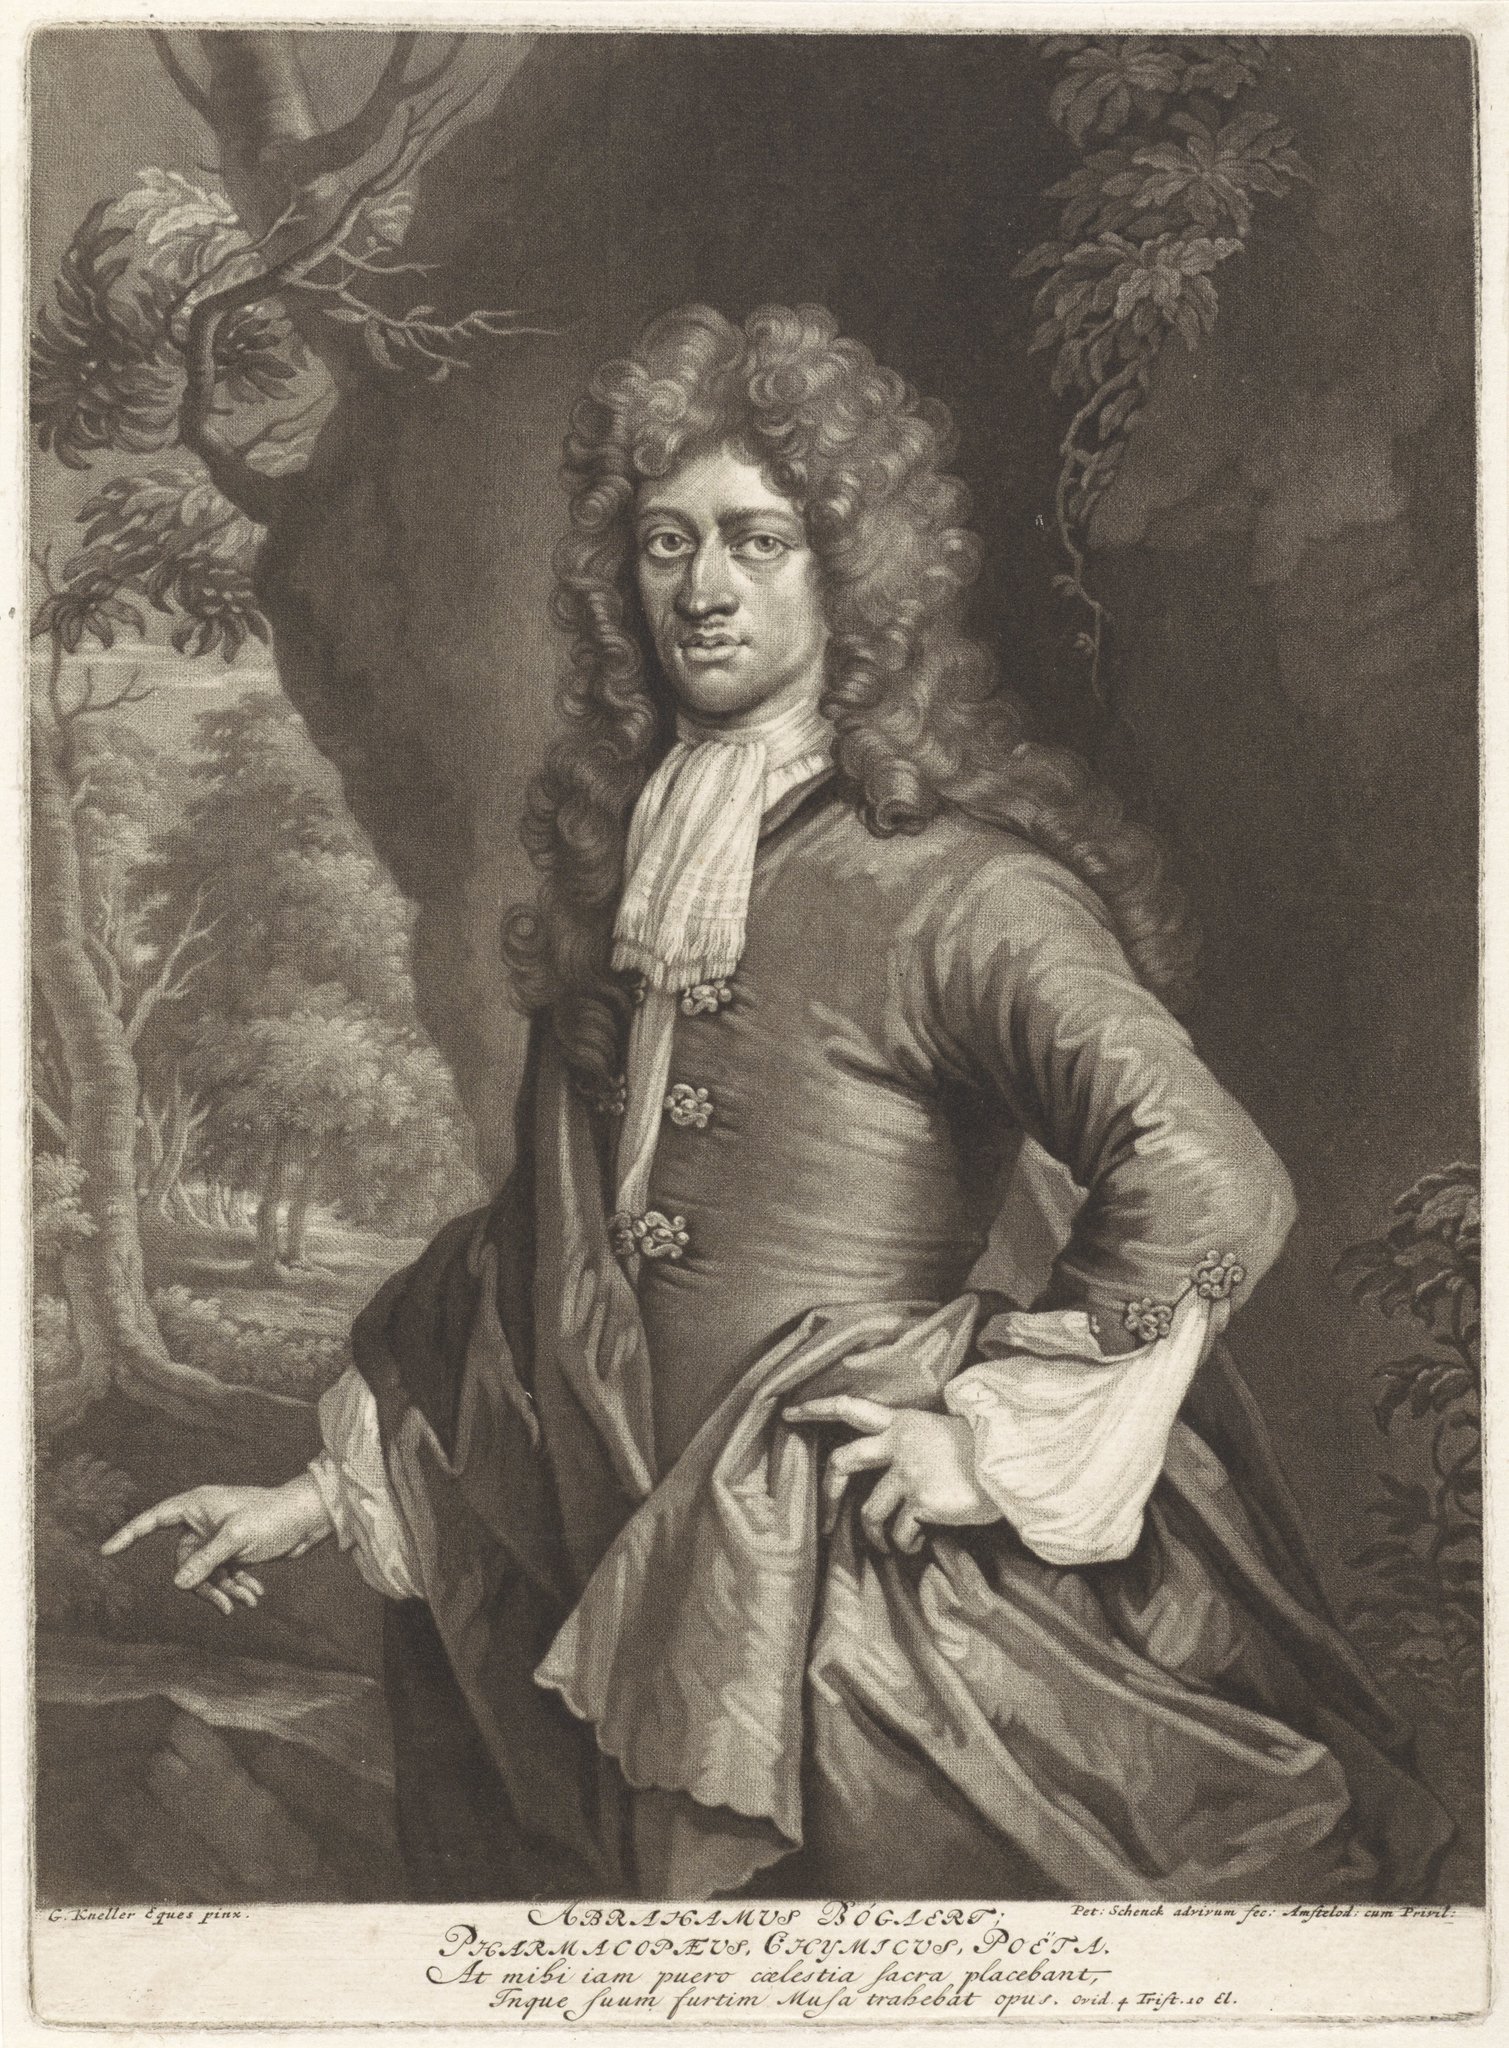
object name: print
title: Portret van Abraham Bogaert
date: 1670-1713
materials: paper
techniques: engraving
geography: amsterdam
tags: amsterdam, abraham bogaert, forest, wood, wig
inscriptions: collector's mark: Lugt 2228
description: De apotheker, dichter en prozaschrijver Abraham Bogaert staat voor een boslandschap. Hij maakte, in dienst van de Oostindische Compagnie, reizen naar Oost-Indië en Zuidoost-Azië.